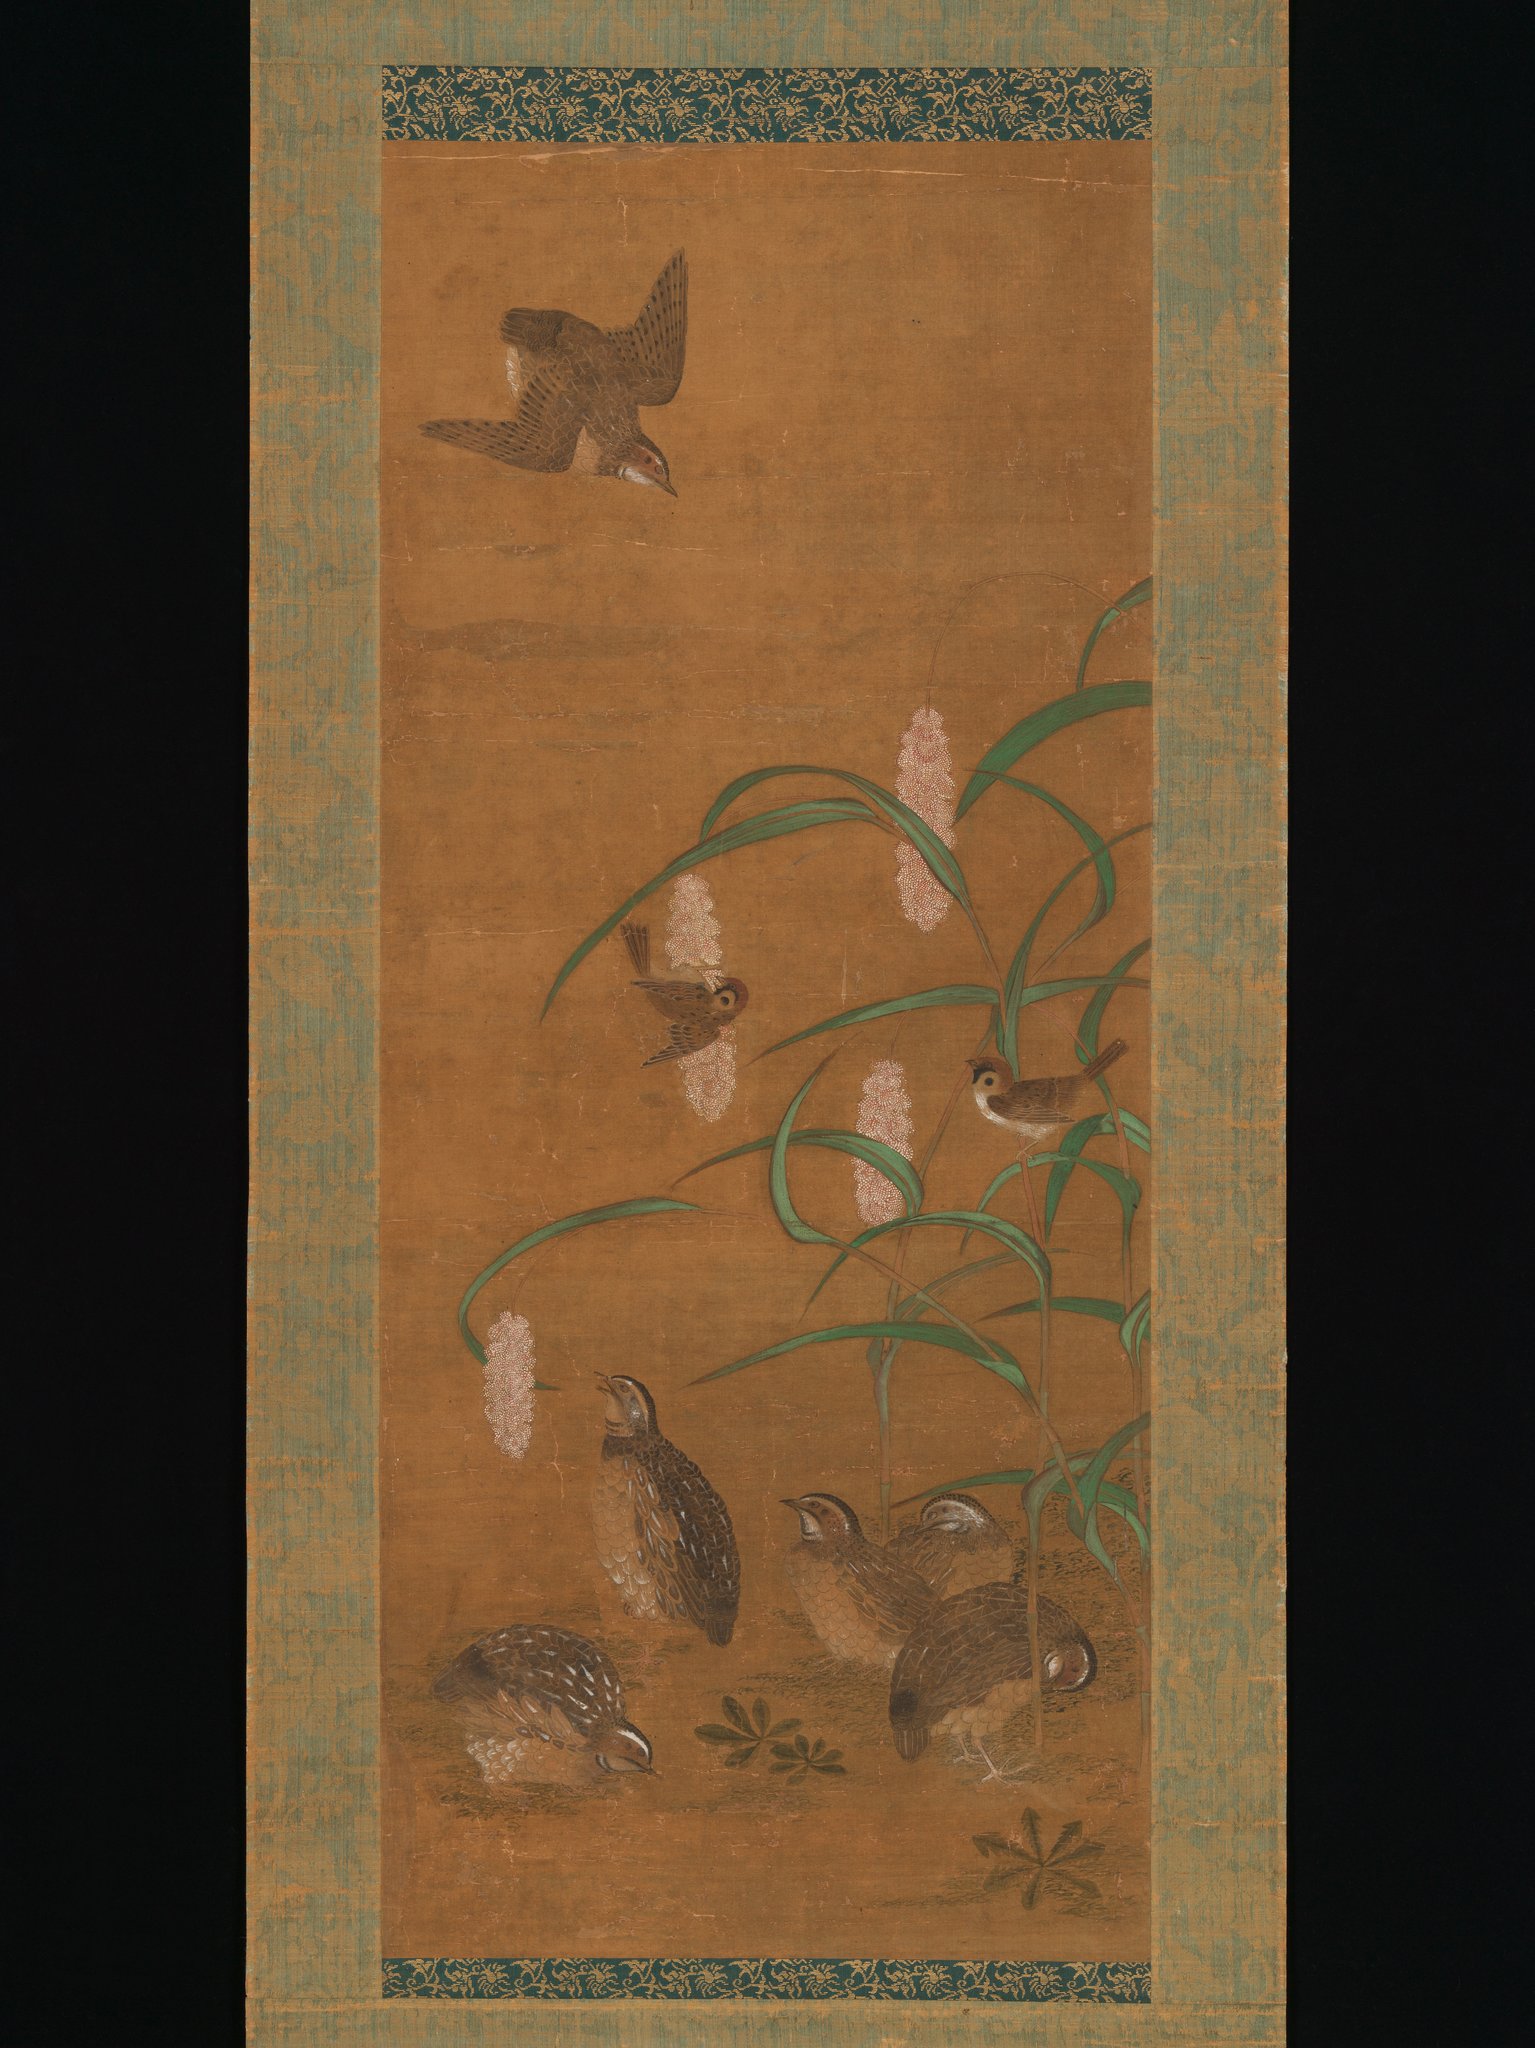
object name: hanging scroll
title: Quail, Sparrows, and Millet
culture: japanese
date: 1501-1533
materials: ink, silk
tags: birds